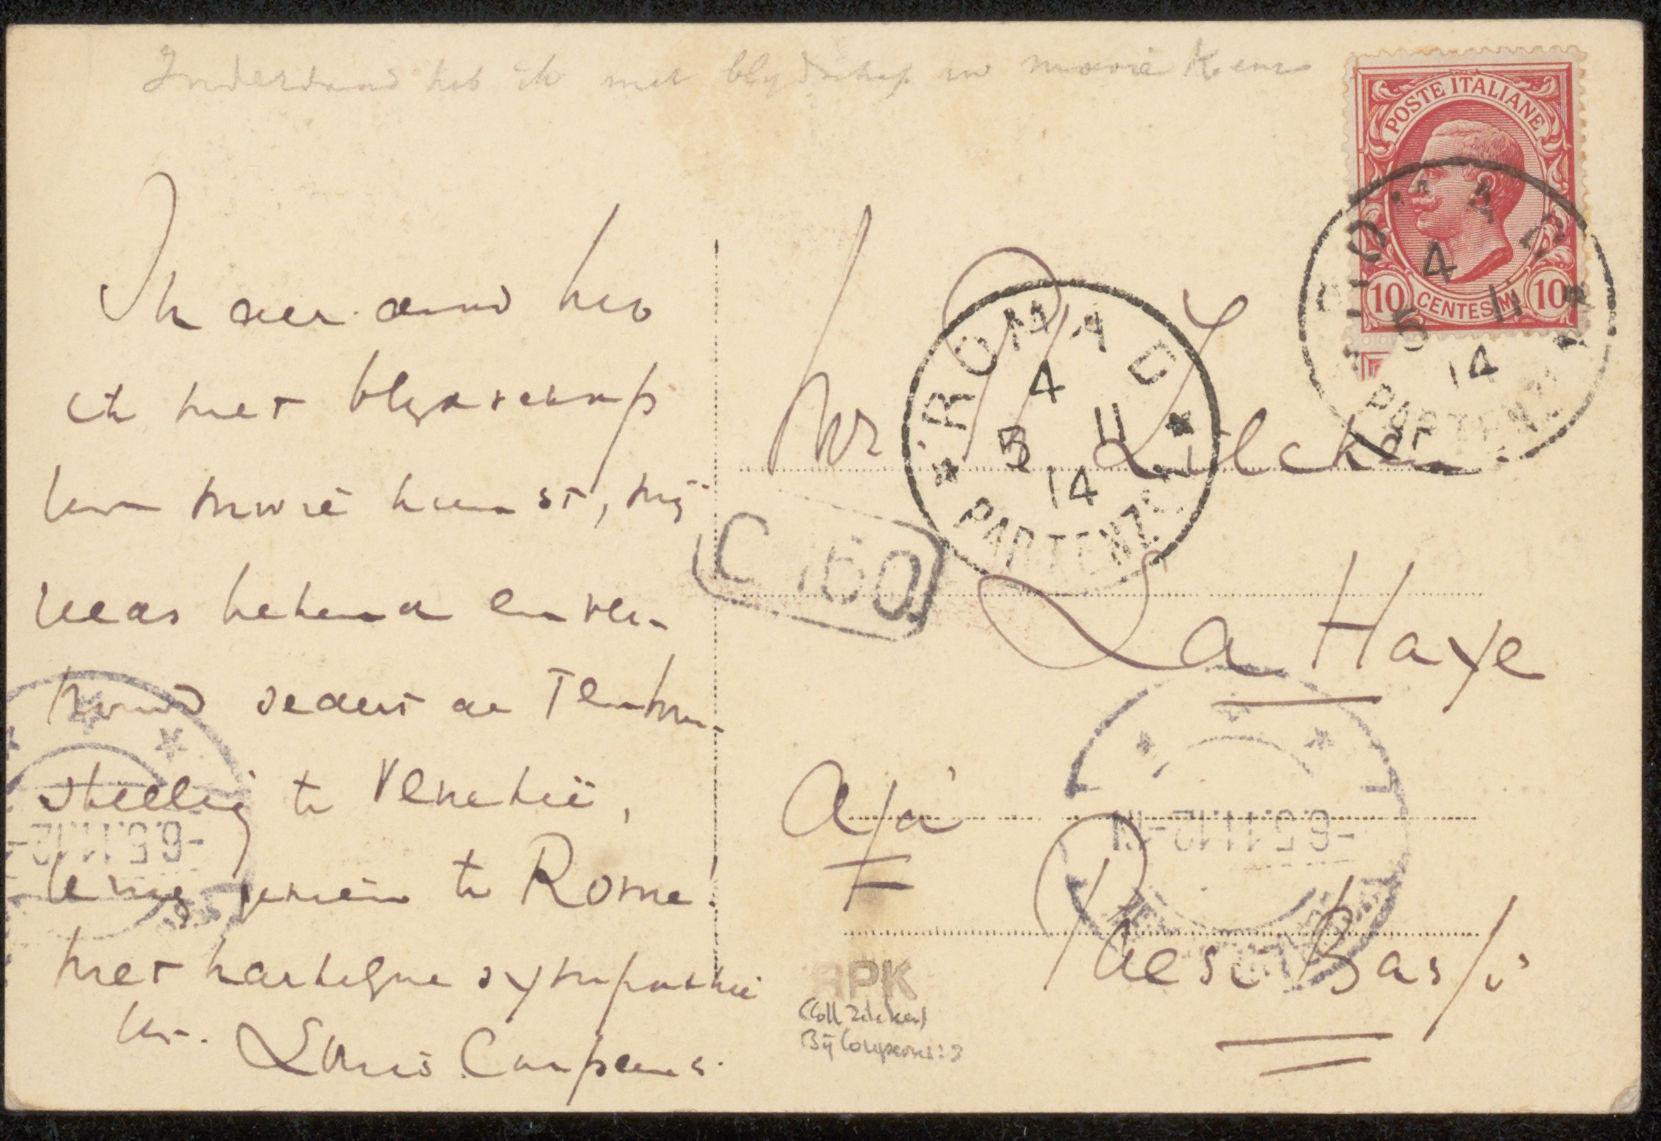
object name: ansichtkaart, prentbriefkaart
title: Prentbriefkaart aan Philip Zilcken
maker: louis couperus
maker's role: romanschrijver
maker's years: 1863-1923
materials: cardboard, ink, pencil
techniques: photograph, pen, writing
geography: rome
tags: painter, draughtsman, philip zilcken, venice, rome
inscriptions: collector's mark: ‘RPK’